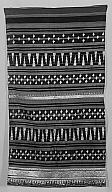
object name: skirt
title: Woman's Ceremonial Skirt (Tapis)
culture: lampung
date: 1801-1900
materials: cotton, gold, silk, thread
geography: indonesia